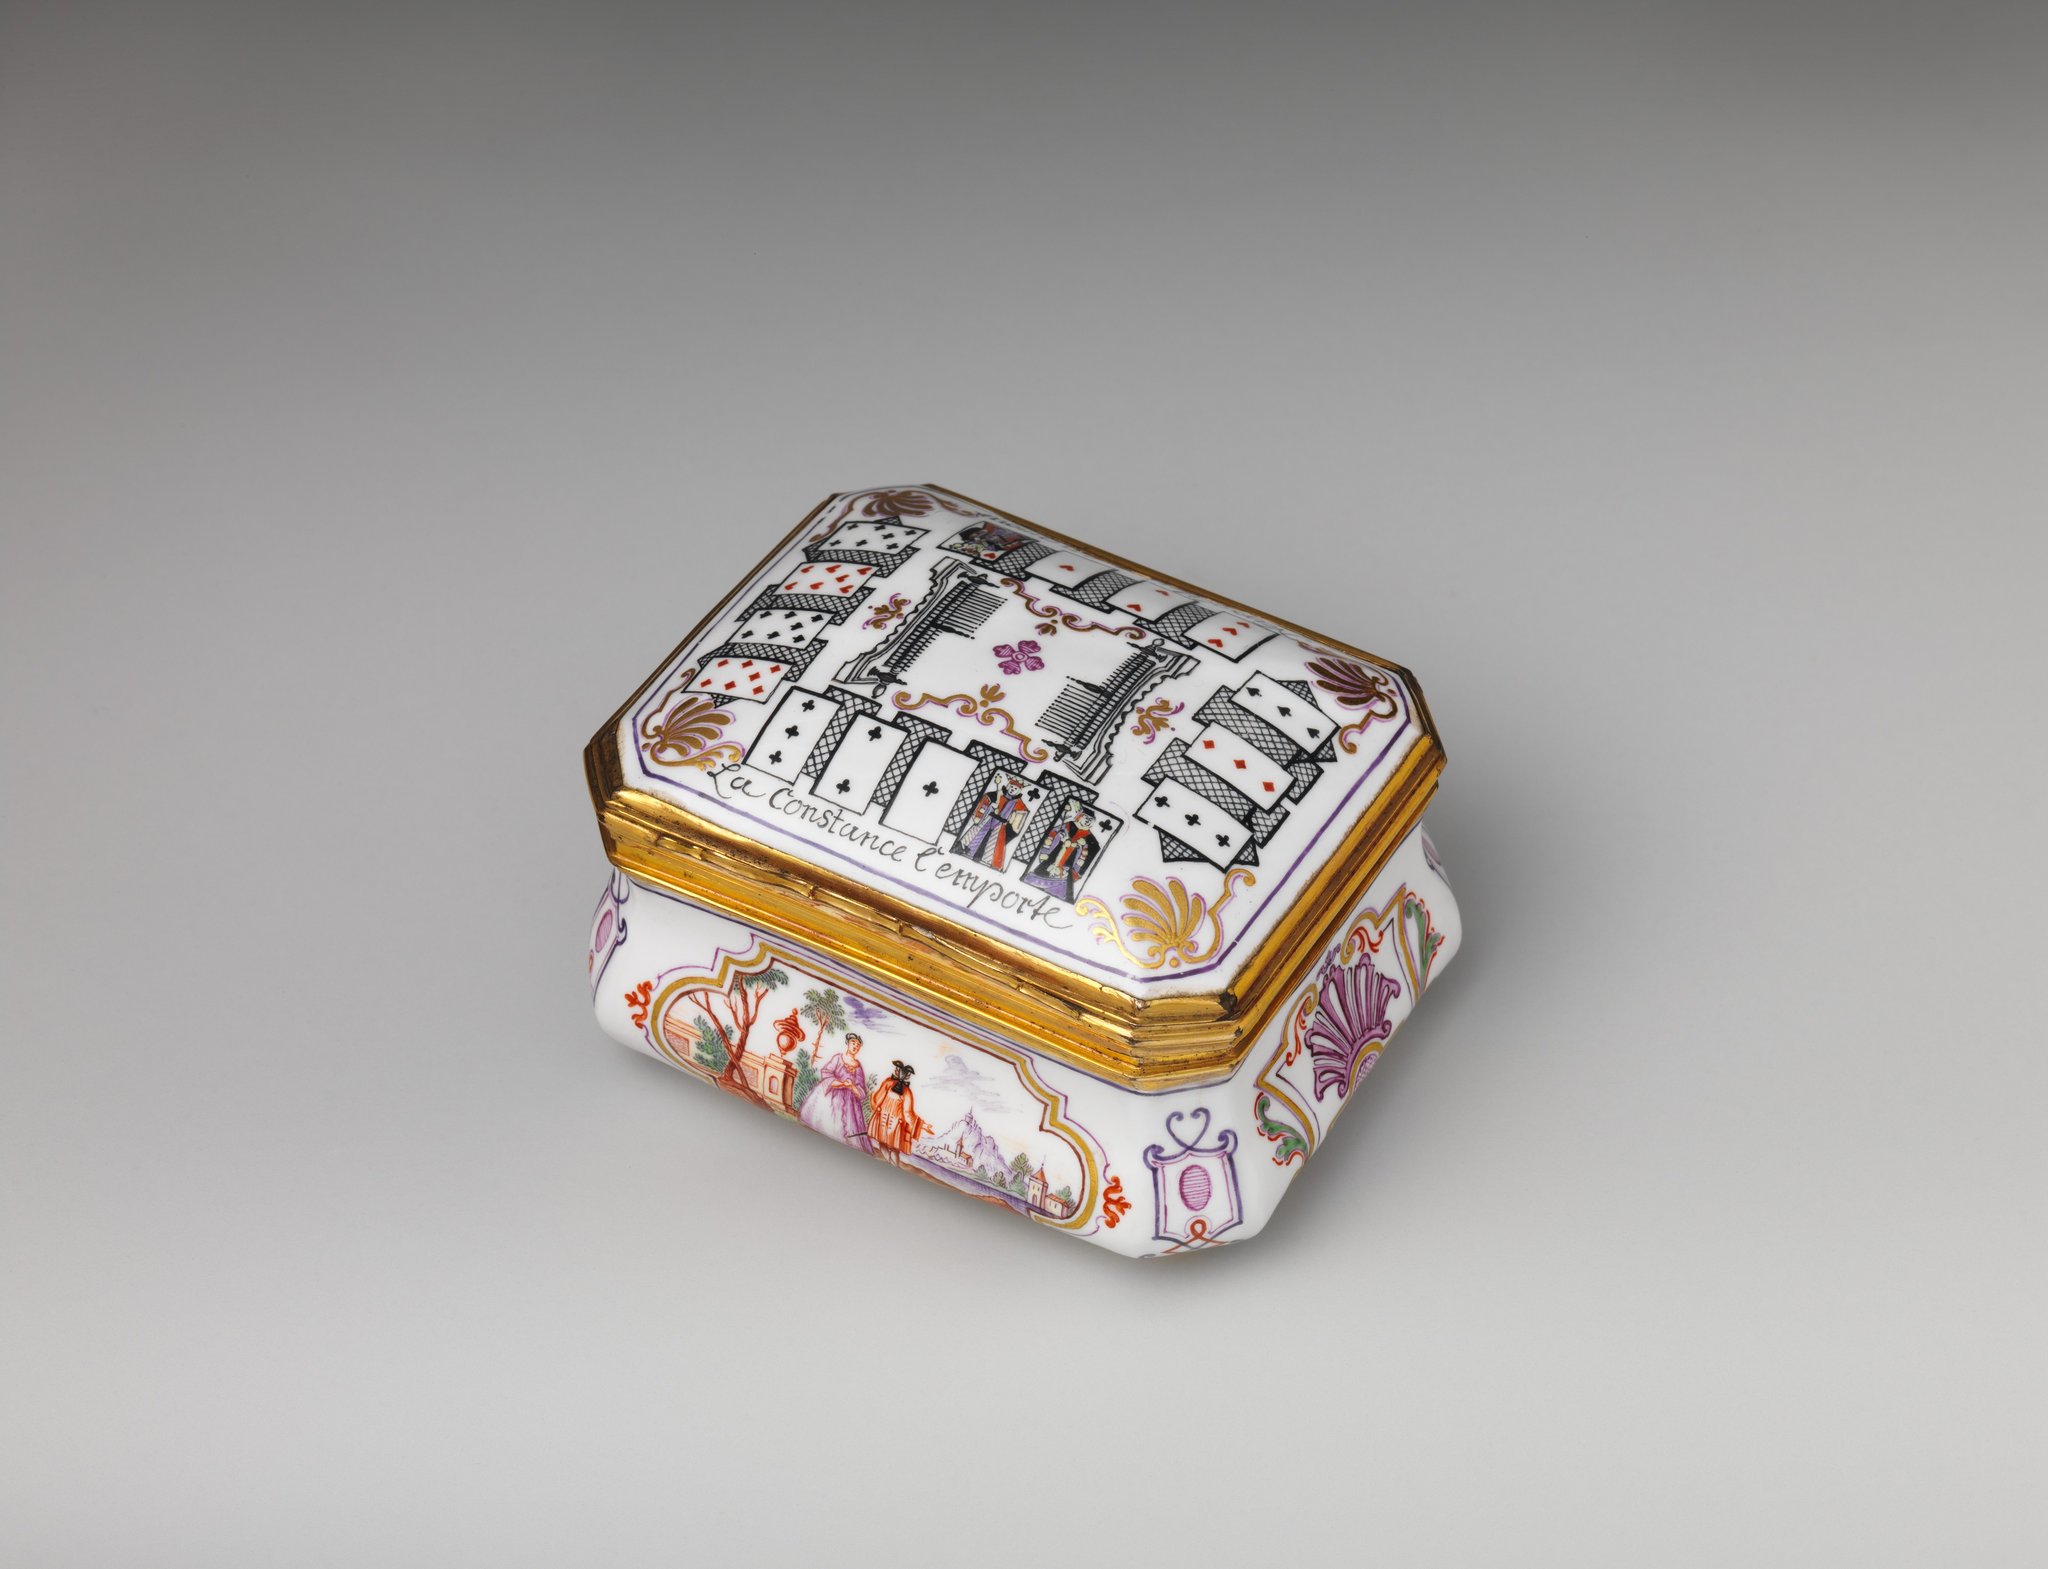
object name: snuffbox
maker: vienna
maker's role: manufactory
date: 1735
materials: gold, hard paste porcelain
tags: human figures,chess,playing cards